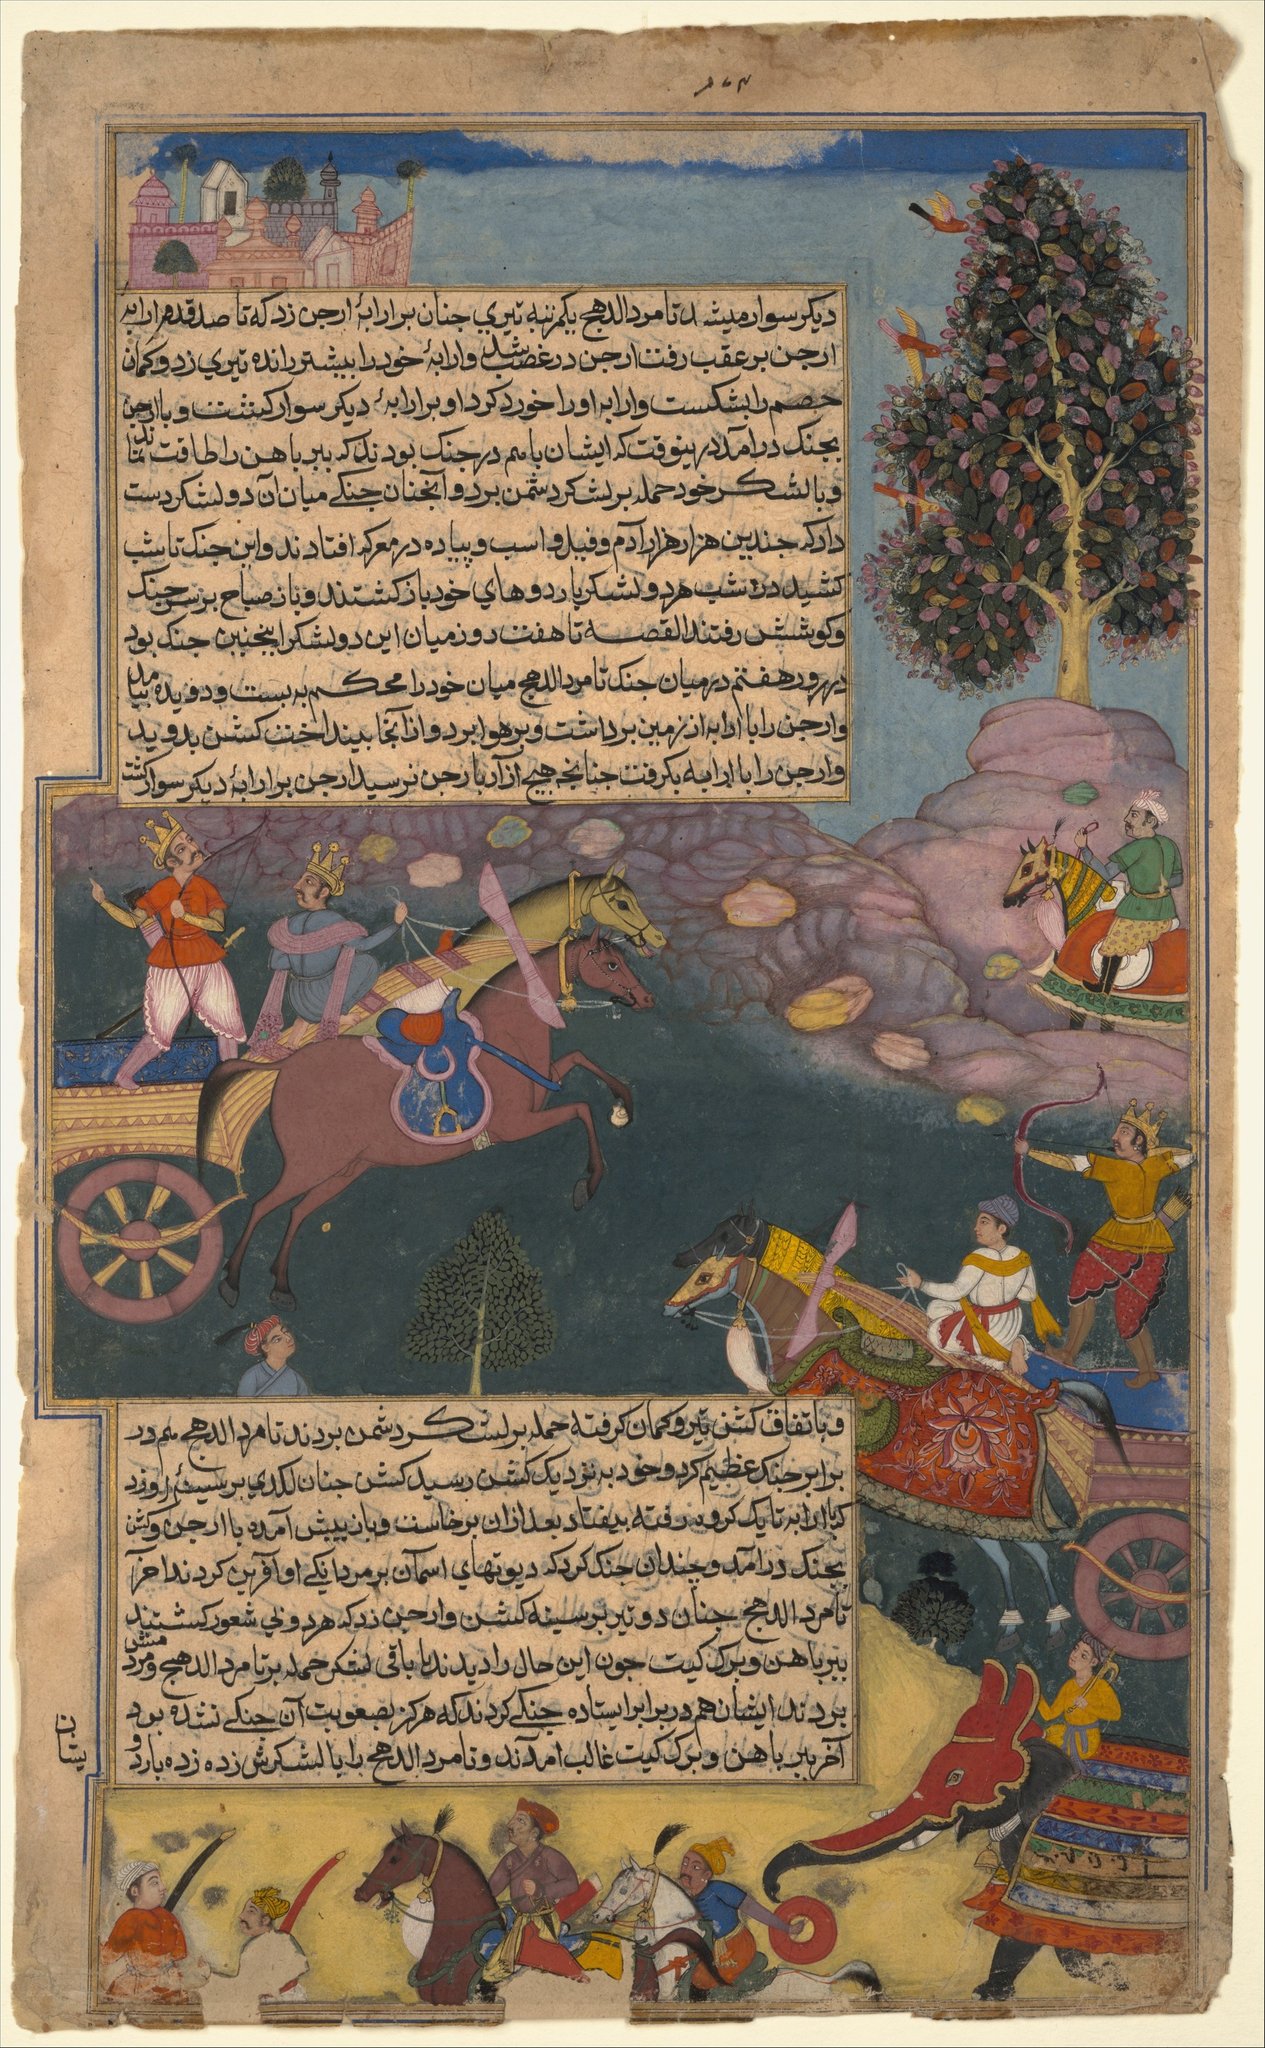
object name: folio from an illustrated manuscript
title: "Arjuna Battles Raja Tamradhvaja", Folio from a Razmnama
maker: 'abd al-rahim ibn muhammad bairam khan khan-i khanan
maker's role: patron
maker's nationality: indian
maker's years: 1556-1627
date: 1616-1617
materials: gold, ink, paper, watercolor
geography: india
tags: battles,bow and arrow,men,horses,chariots